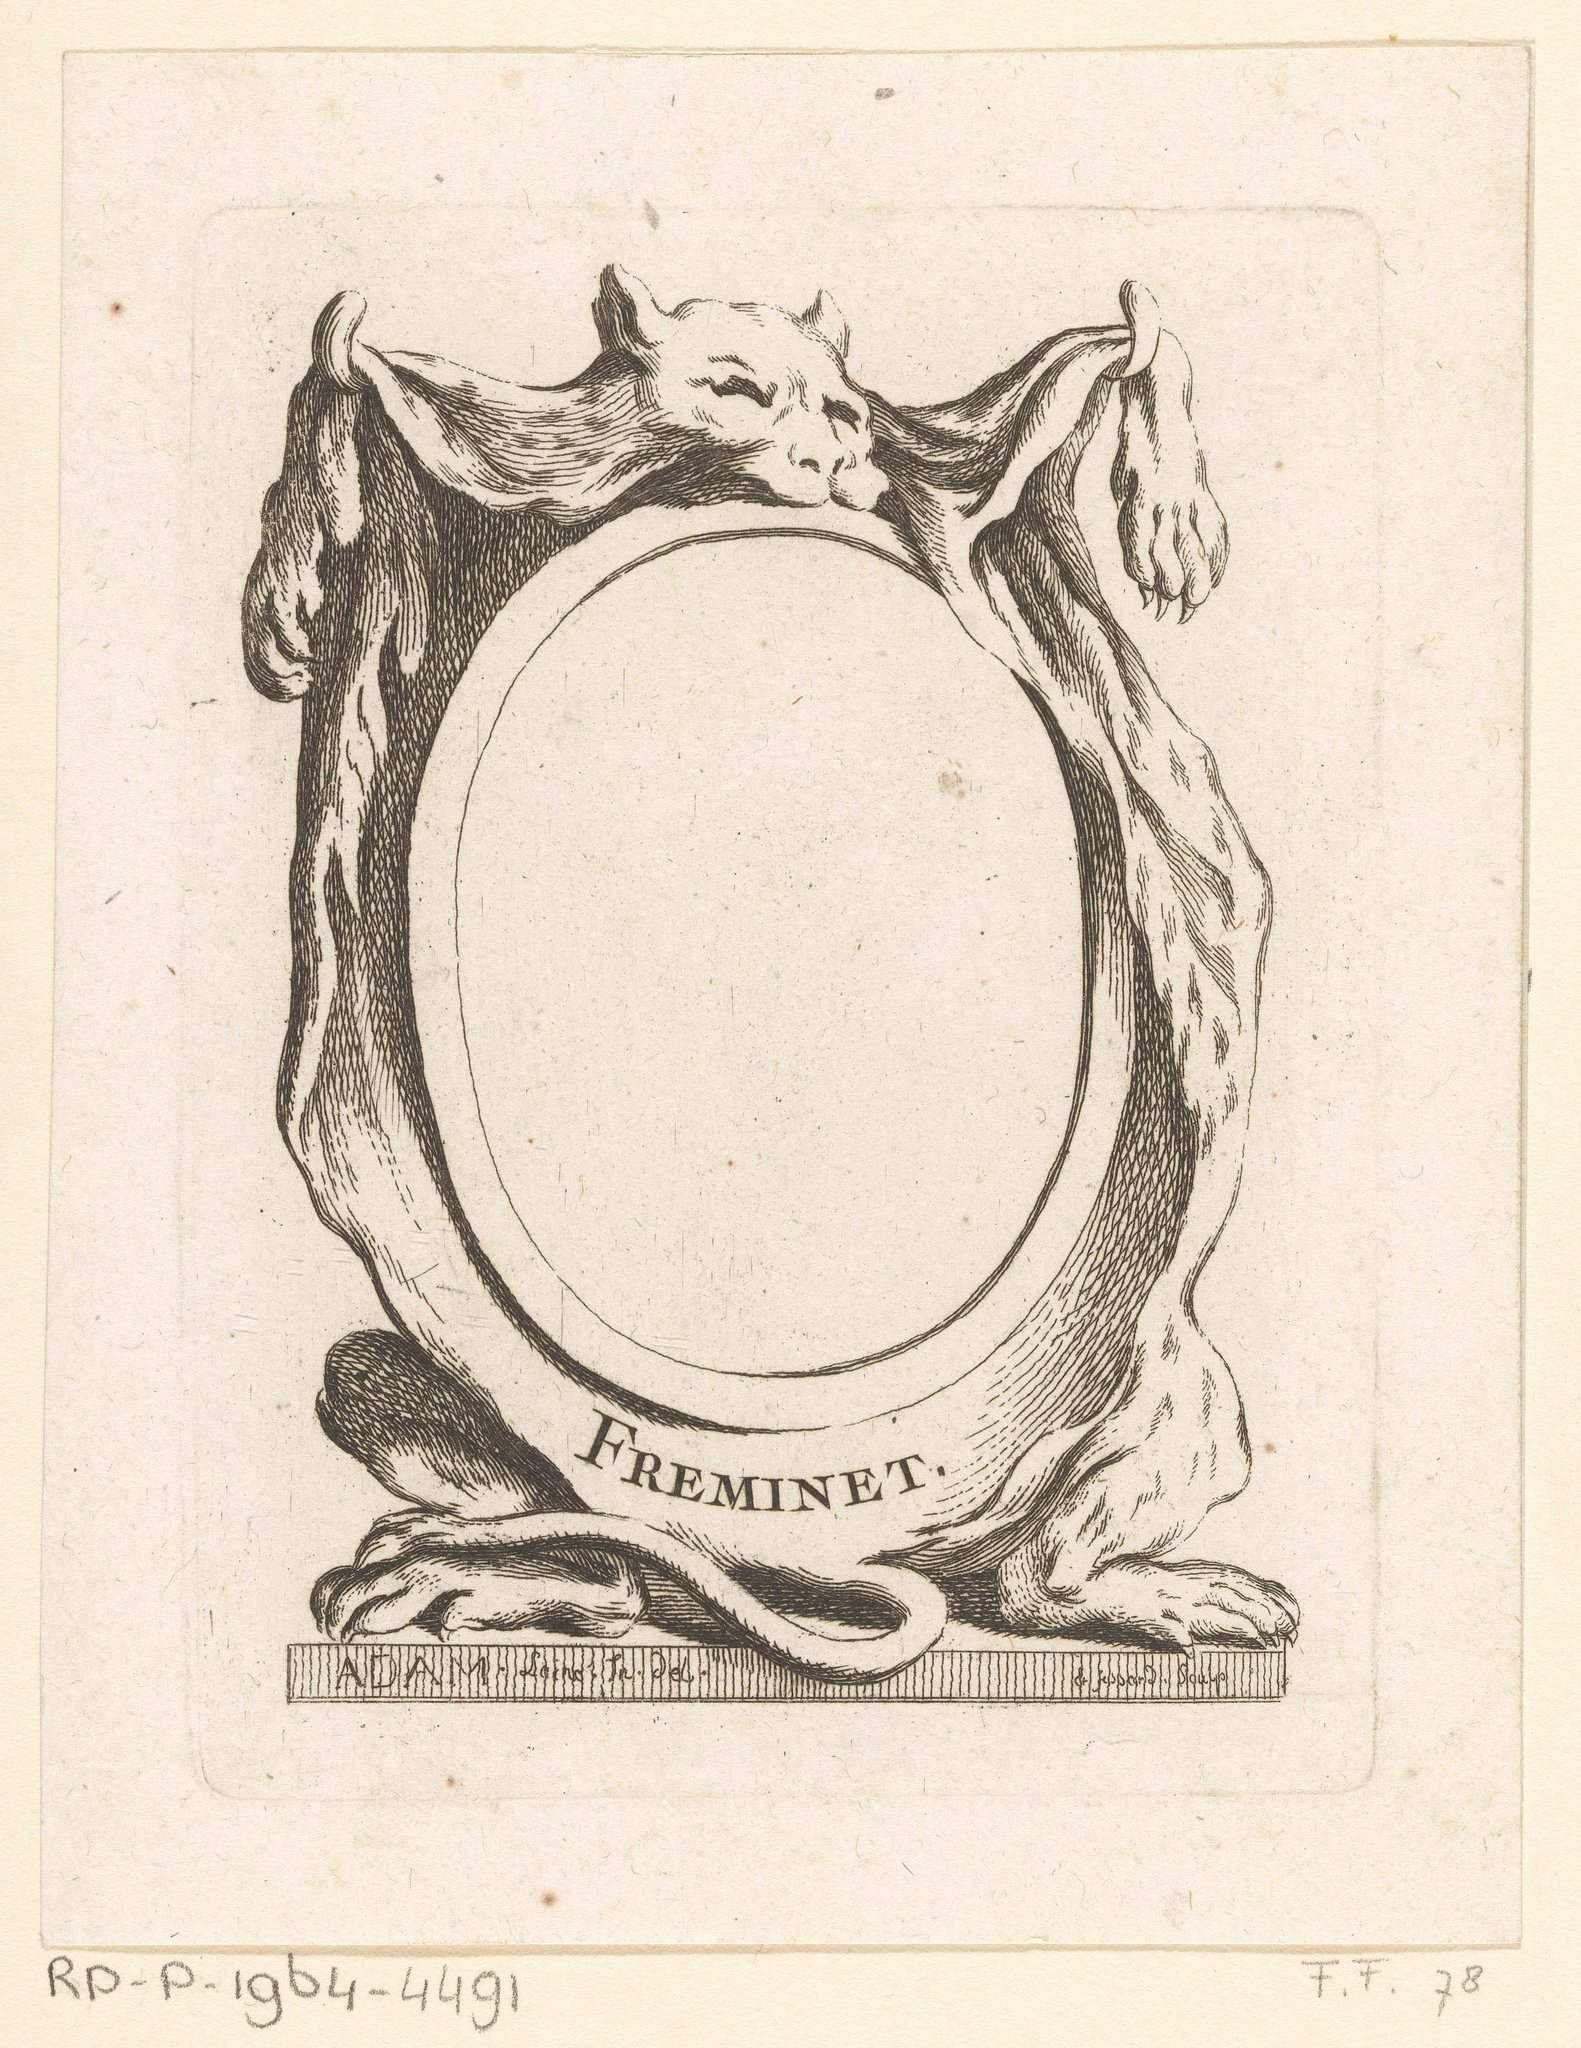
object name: print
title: Omlijstingen voor kunstenaarsportretten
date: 1724-1777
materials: paper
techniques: etching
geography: france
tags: ornaments ~ art (+ framing decorations), artist (in general)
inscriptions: collector's mark: Lugt 2760, collector's mark: Lugt 2228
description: Een ovale omlijsting met een vel van een katachtige voor Freminet (Martin Fréminet).